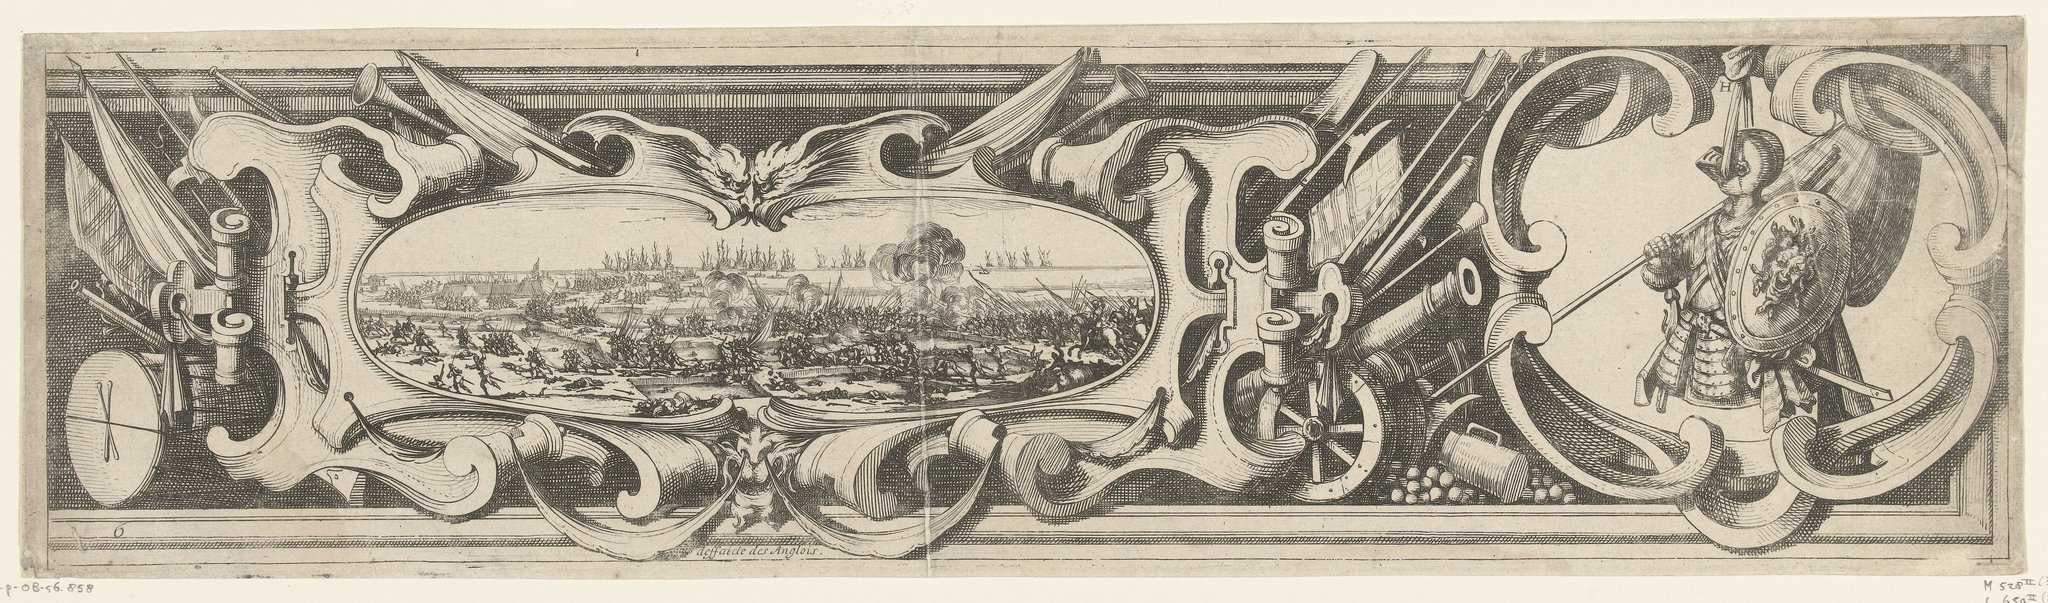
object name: print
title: deffaicte des Anglois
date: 1629-1631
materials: paper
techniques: engraving, etching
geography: paris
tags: battle, ships (in general), ornament ~ cartouche, siege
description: Zestiende deel (randwerk, deel rechtsonder) van een prent van het beleg van de citadel Saint Martin op het Île de Ré in 1627, dat werd uitgevoerd door Engelse troepen onder leiding van de hertog van Buckingham en werd beëindigd door Franse troepen onder leiding van kardinaal Richelieu. Op dit blad rechts een harnas en midden/links een voorstelling (omgeven door militaire attributen) van een gevecht tussen Engelse en Franse soldaten.